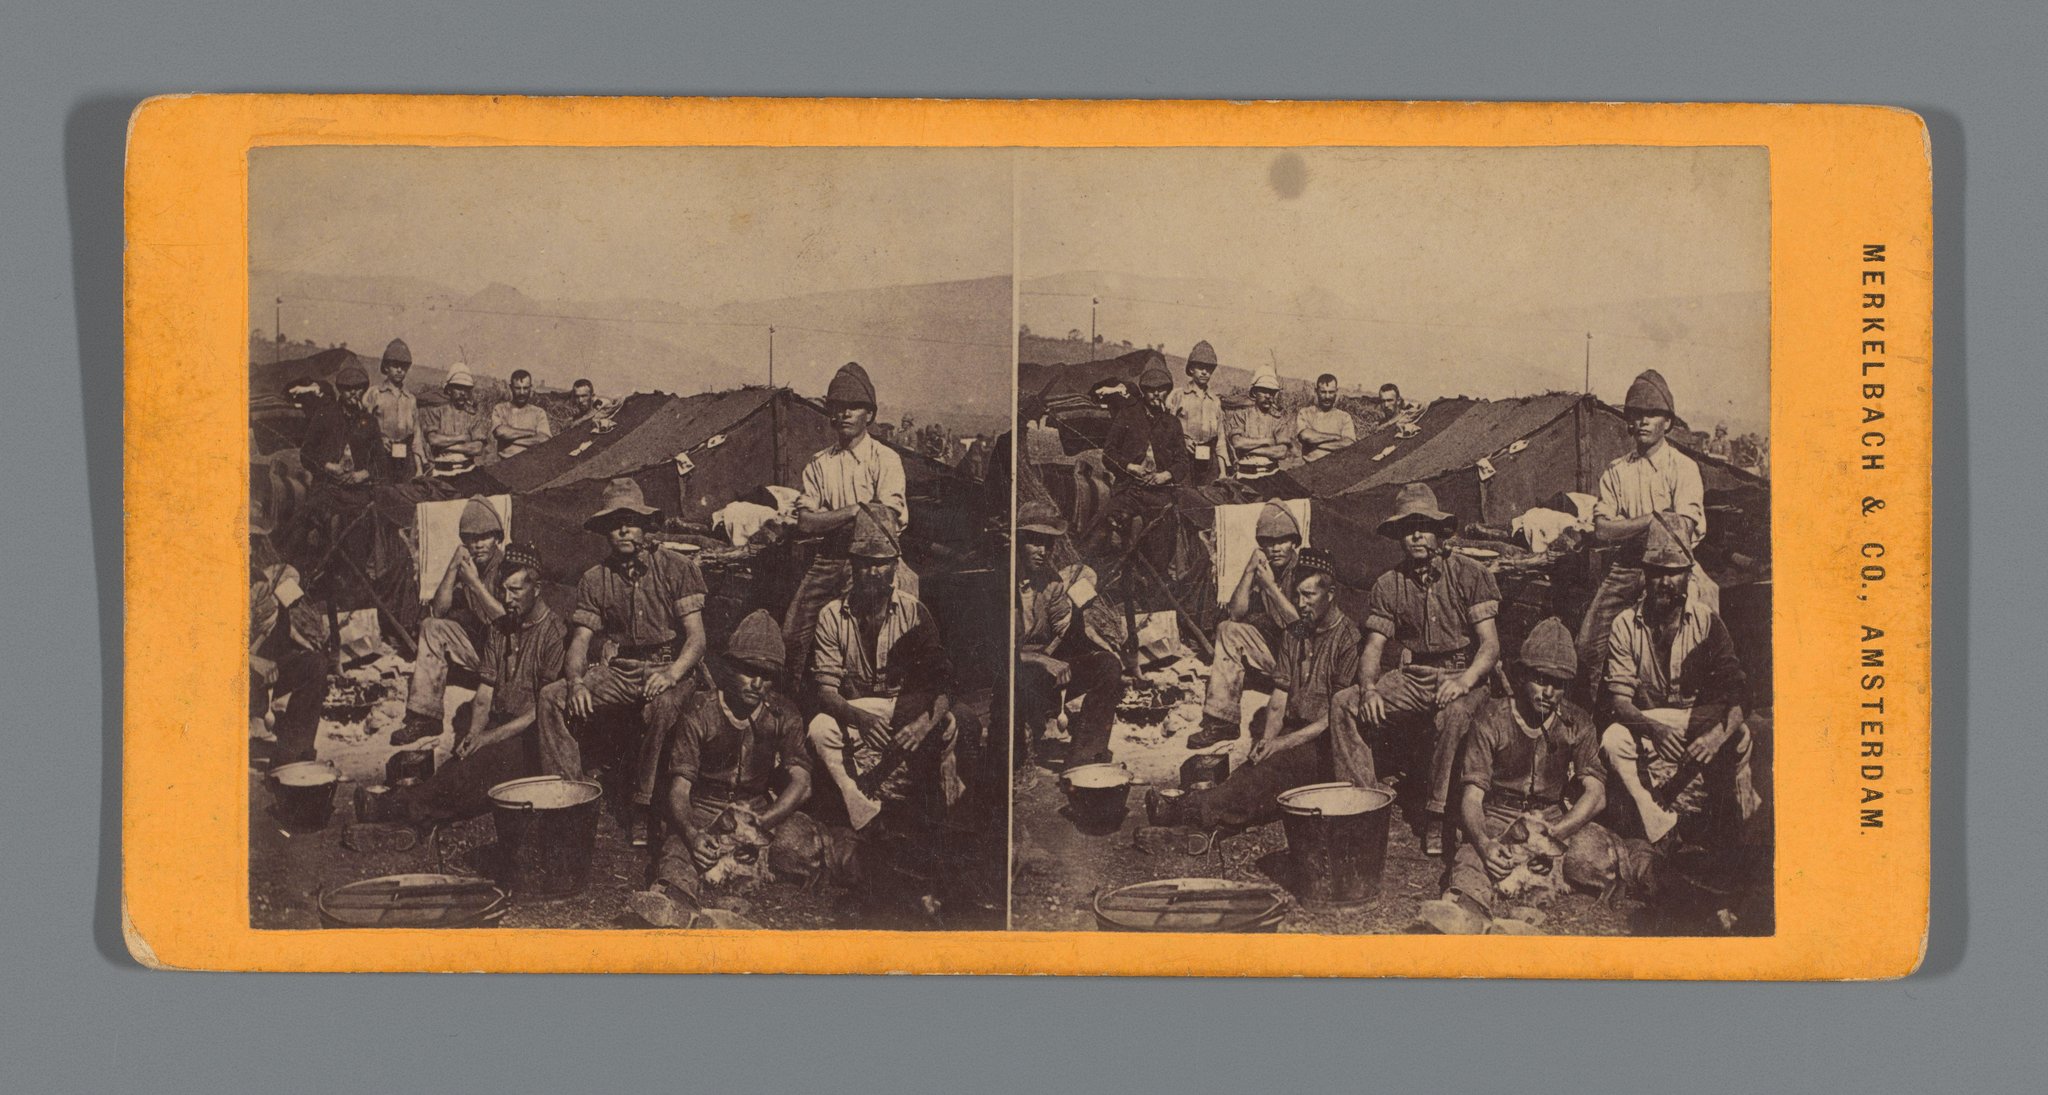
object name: stereograph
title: Aardrijkskundige Beeldengalerij, verzameld door M.J. Broekhuijsen, Hoofd eener school te Amsterdam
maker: martien johan broekhuijsen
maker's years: 1871-1956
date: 1905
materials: photographic support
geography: amsterdam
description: Onderdeel van een groep van 52 stereofoto's gebruikt in het lager onderwijs als aanvulling op schoolplaten. De gehele reeks bestond uit 274 nummers in 10 categorieën (A t/m K).